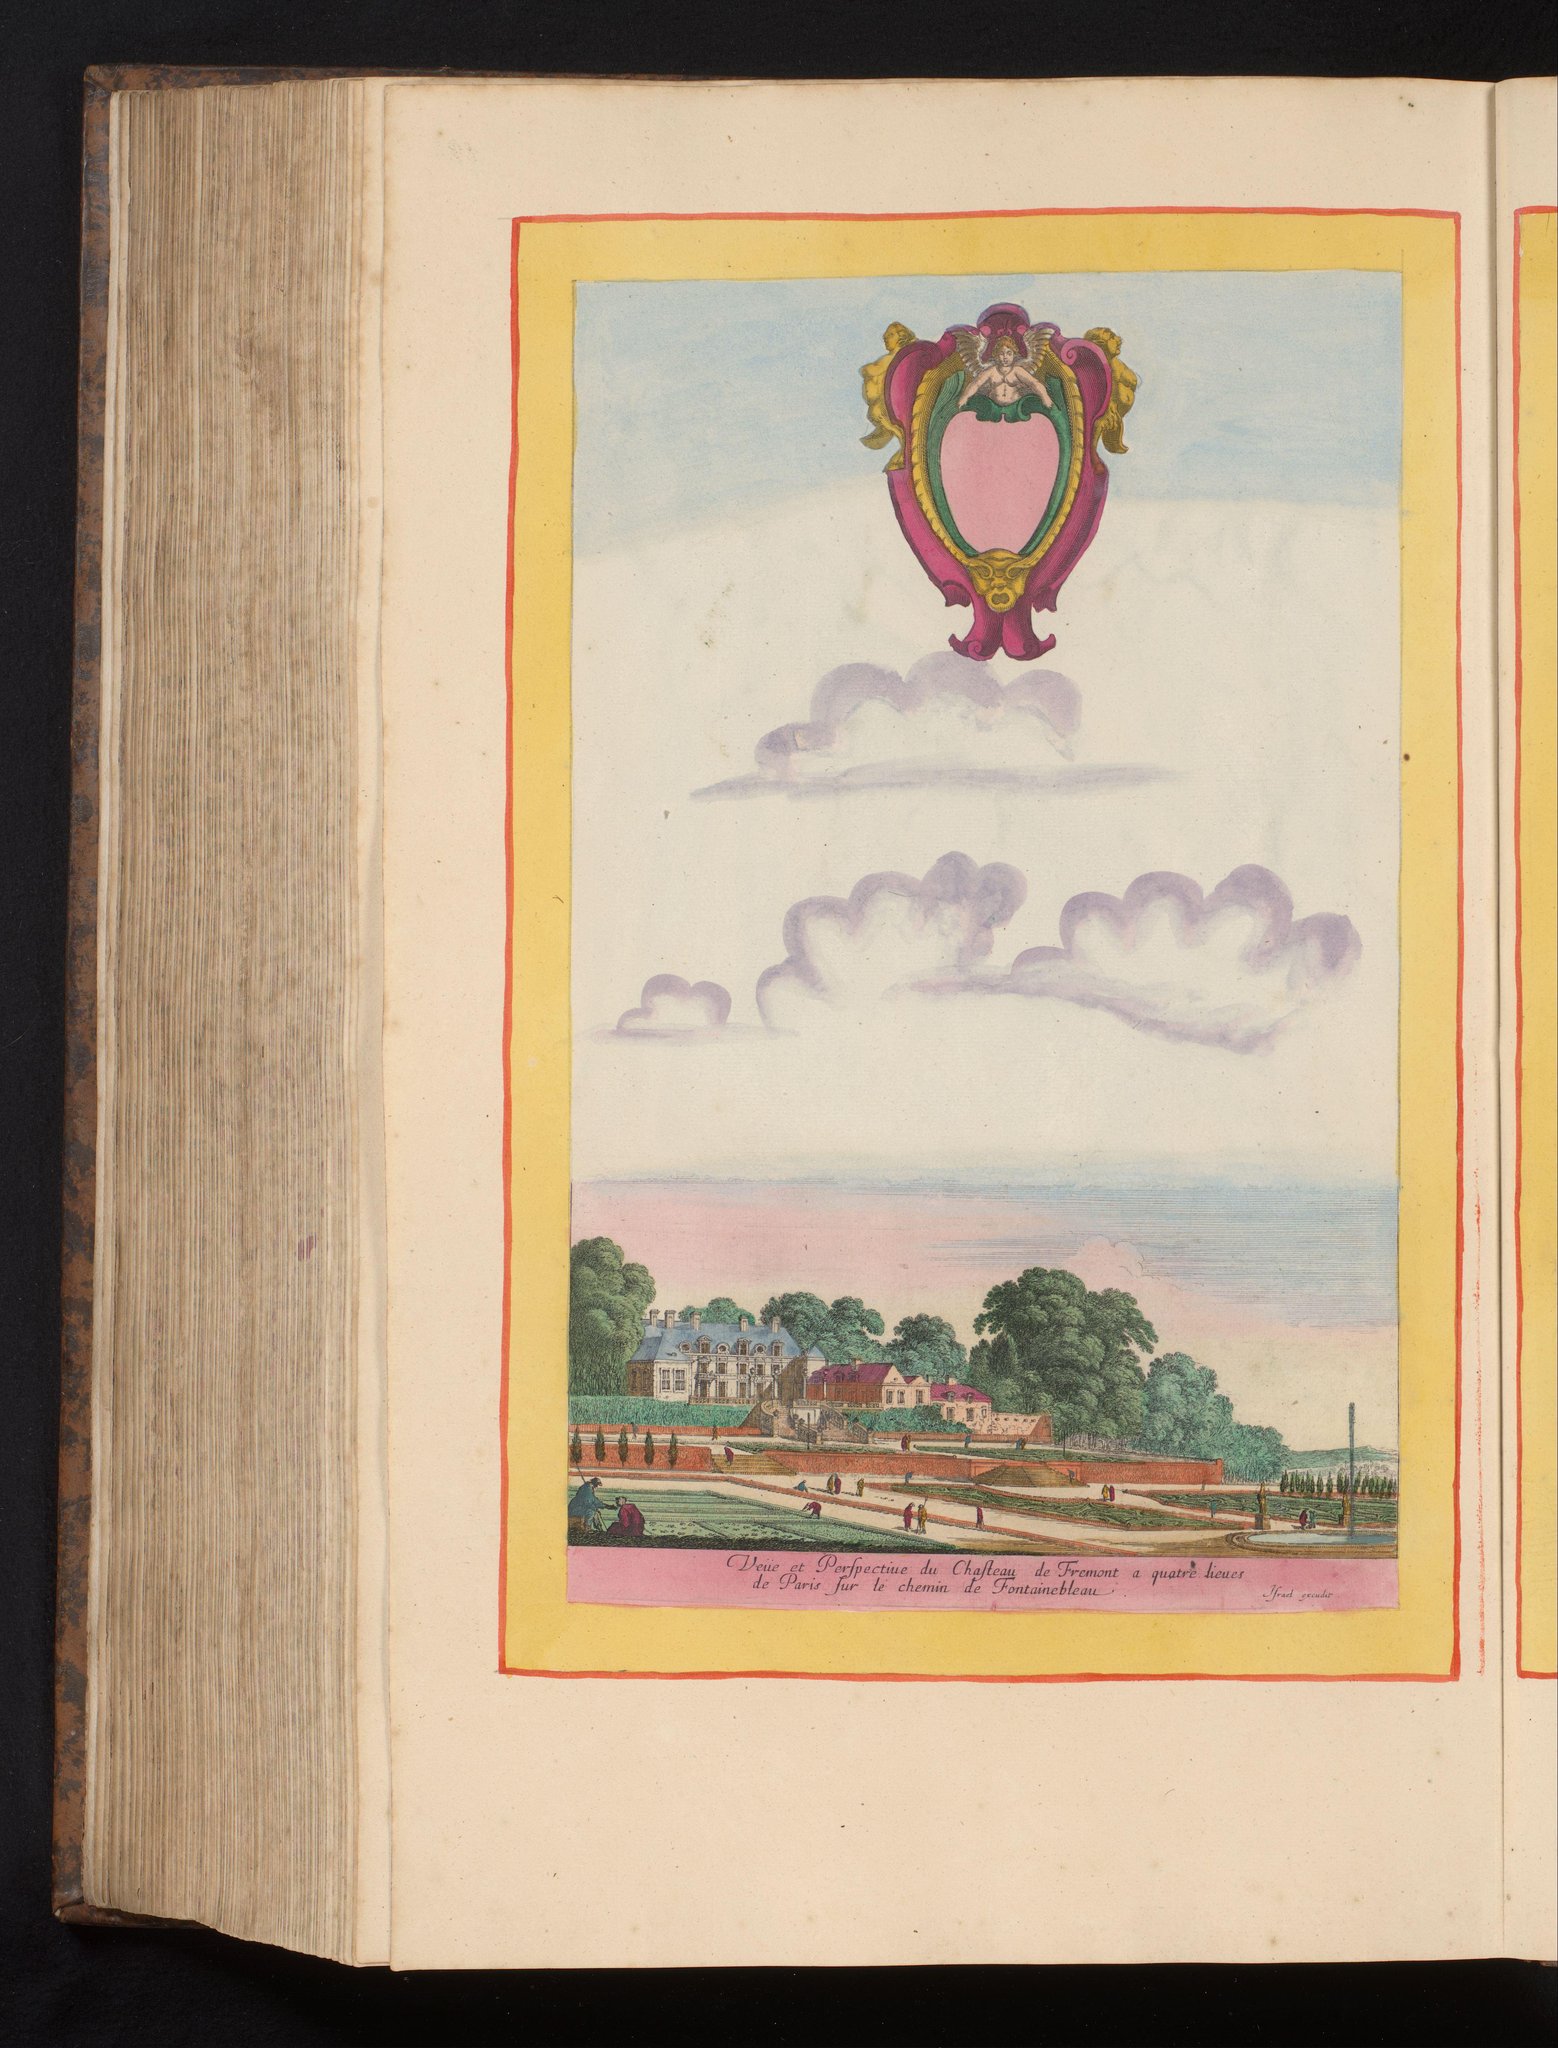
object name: print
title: Gezicht op Château de Fromont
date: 1631-1661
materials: paper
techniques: etching, hand coloring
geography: paris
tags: hôtel, i.e. small palace in city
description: Gezicht op Château de Fromont te Ris-Orangis aan de weg van Parijs naar Fontainebleau. In de lucht een ornamenteel leeg wapenschild. Prent maakt deel uit van een album.